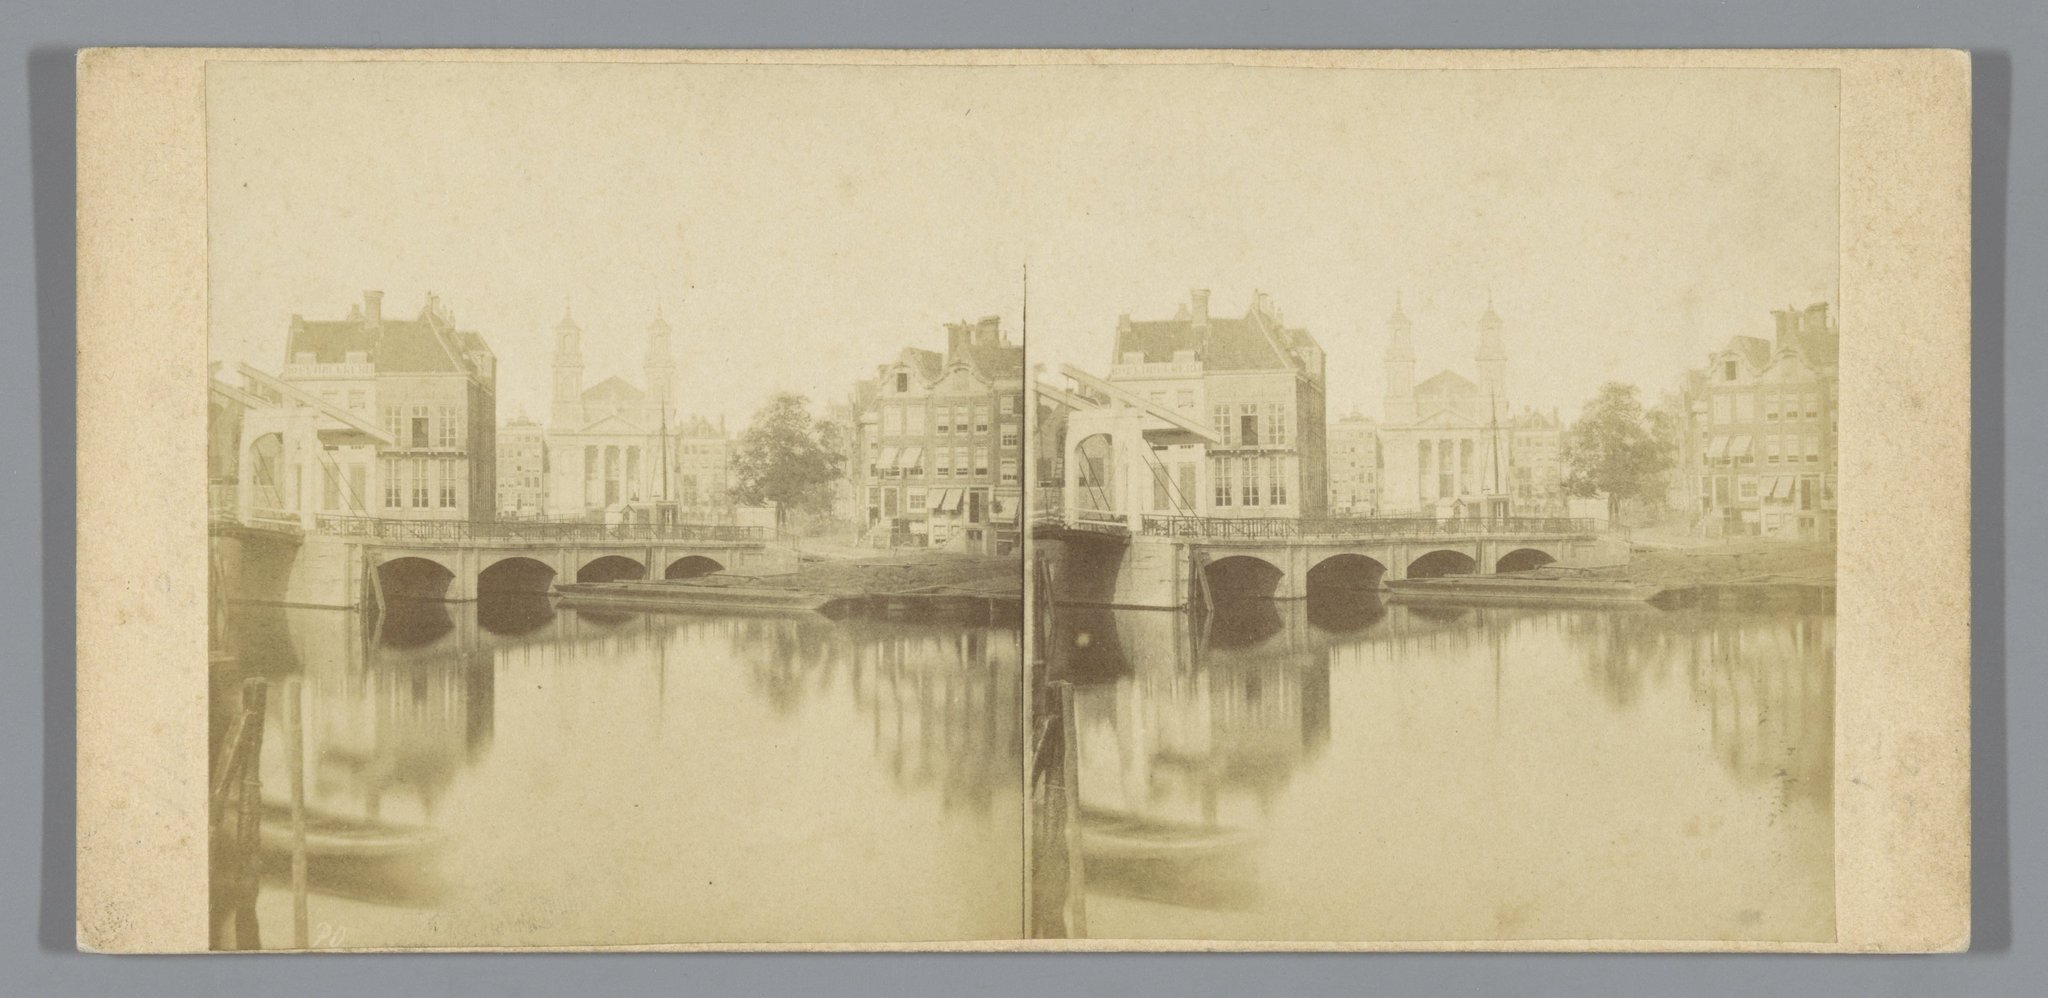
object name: stereograph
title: Vues de Hollande, Amsterdam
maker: pieter oosterhuis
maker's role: draughtsman, print maker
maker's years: 1816-1885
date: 1855-1865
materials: cardboard, paper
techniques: albumen print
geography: amsterdam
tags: church (exterior), bridge in city across river, canal, etc.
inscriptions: number: ‘96’, inscription: ‘2461/ xx/ uj.’, number: ‘No 26’, initials: ‘P.O.’